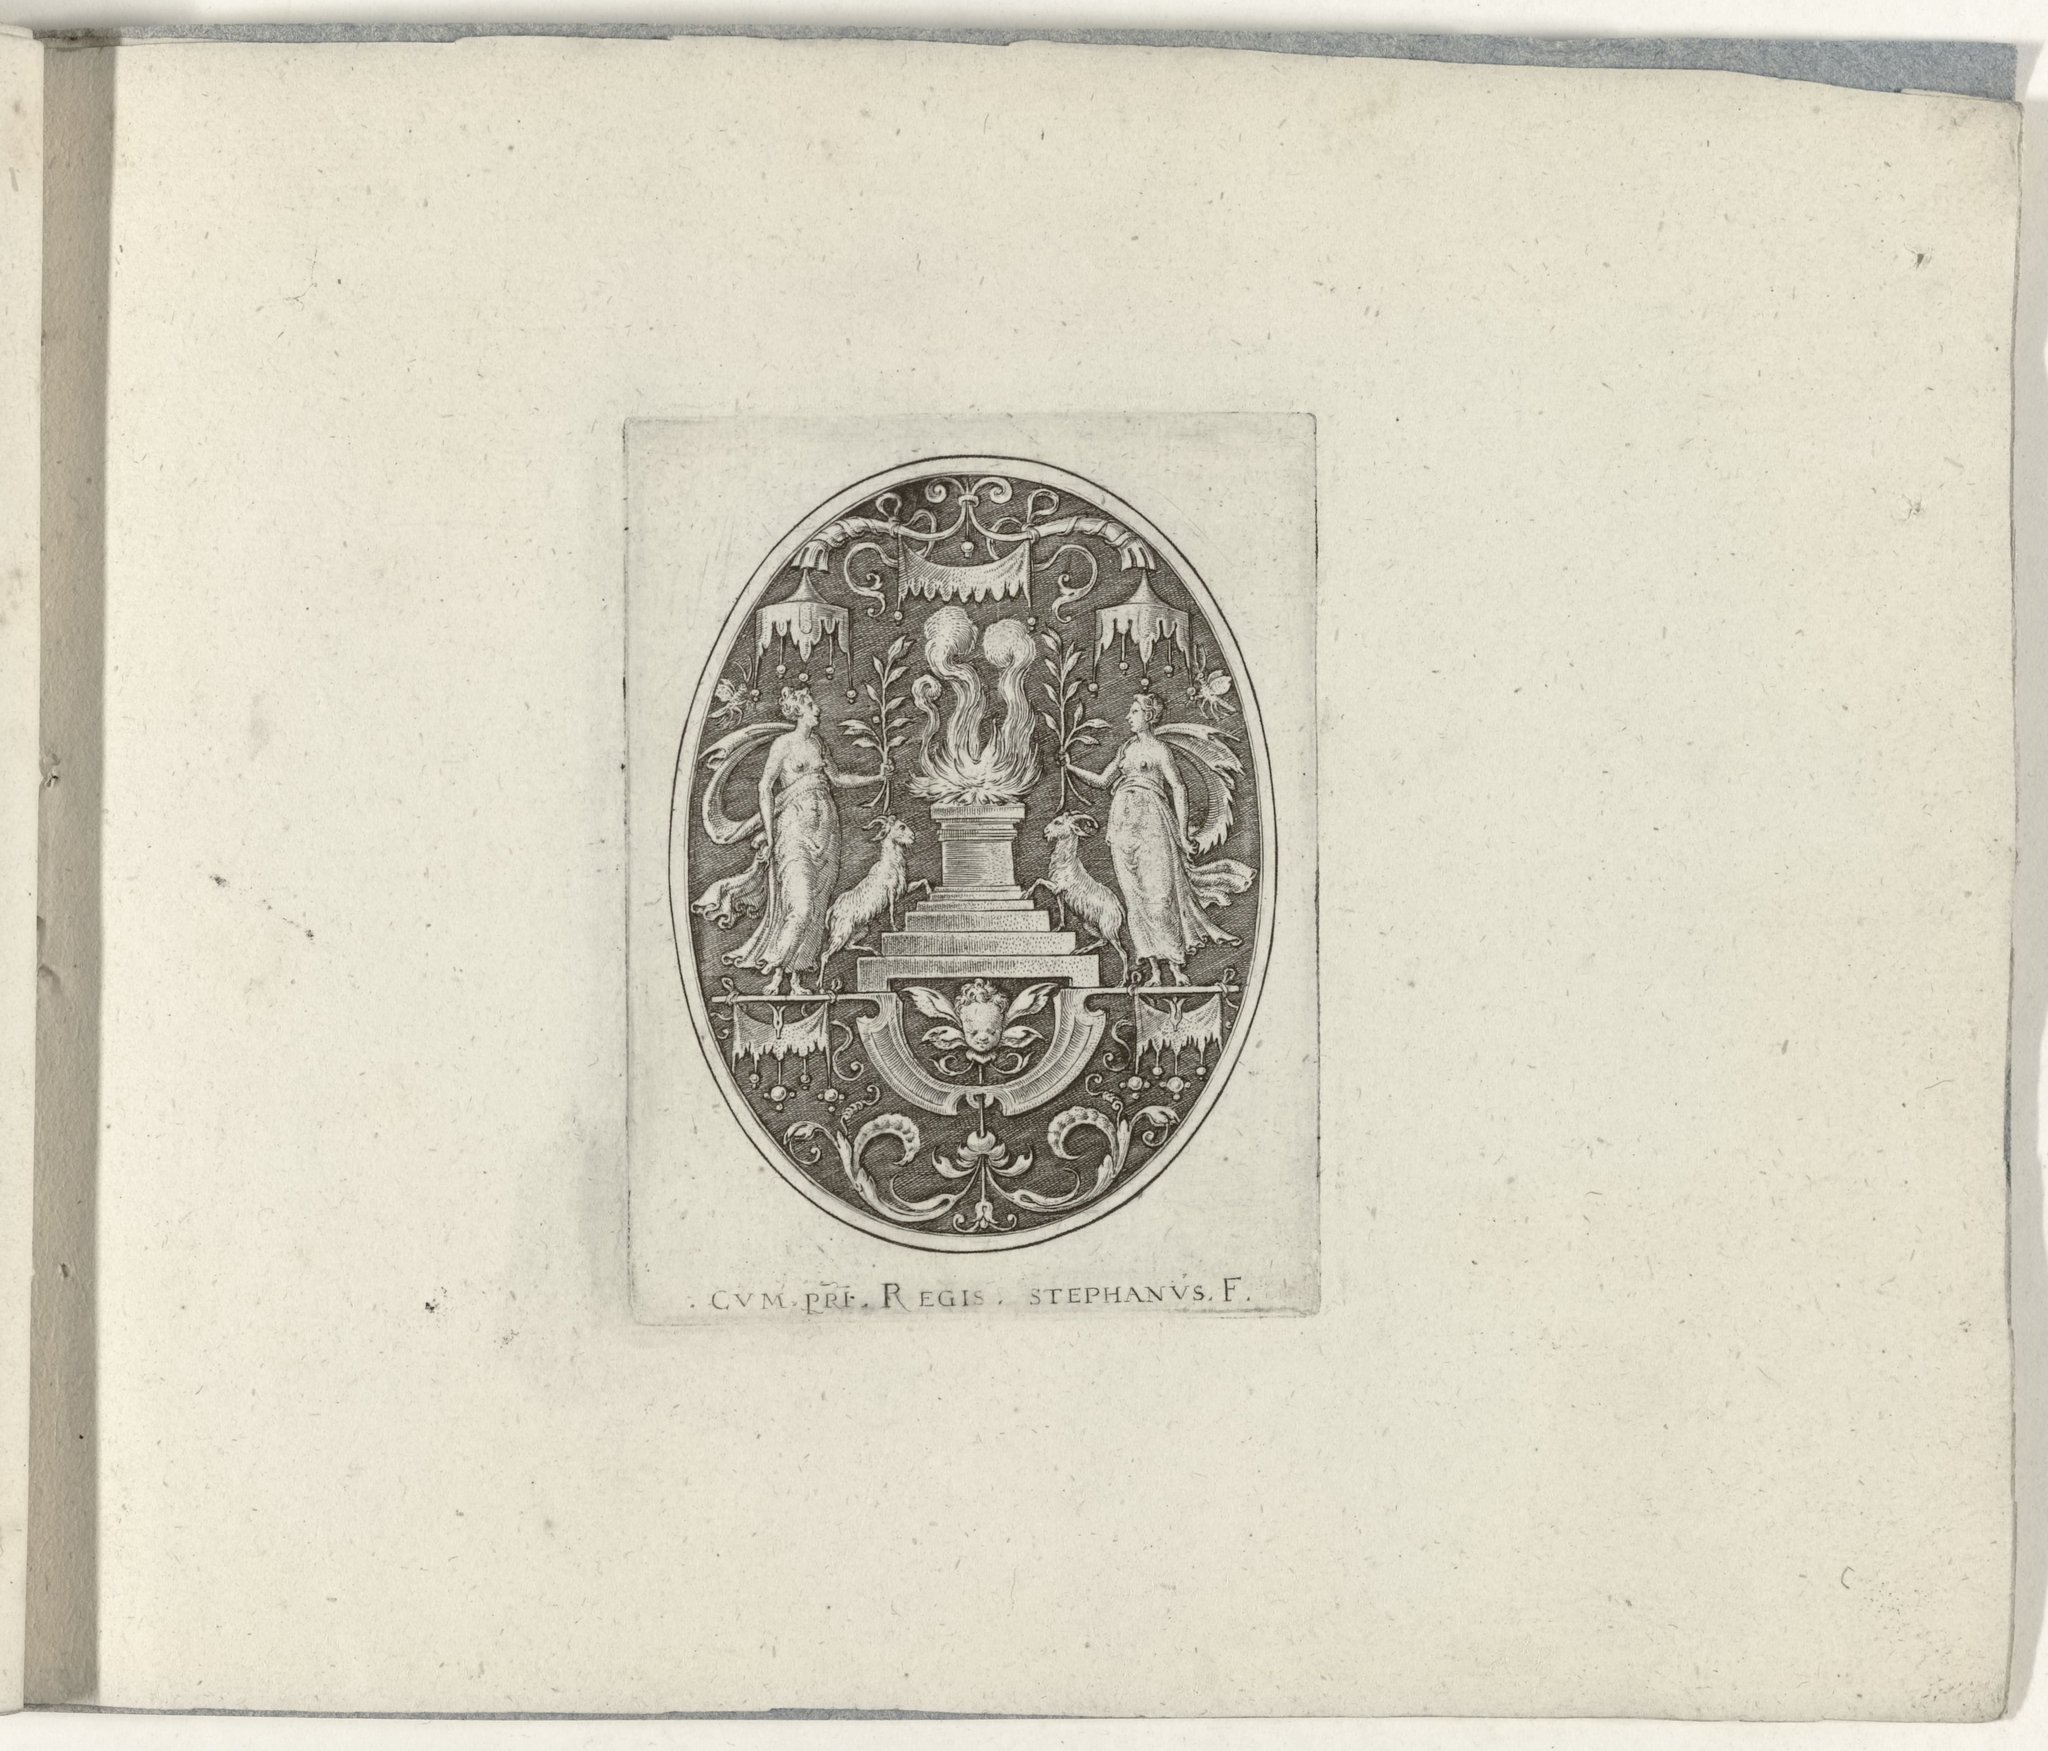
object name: ornament print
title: Altaar met daarop een brandend vuur, geflankeerd door twee bokken en twee vrouwen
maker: etienne delaune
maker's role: draughtsman, goldsmith, print maker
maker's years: 1519-1583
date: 1560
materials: paper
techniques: engraving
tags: anthropomorphic ornament